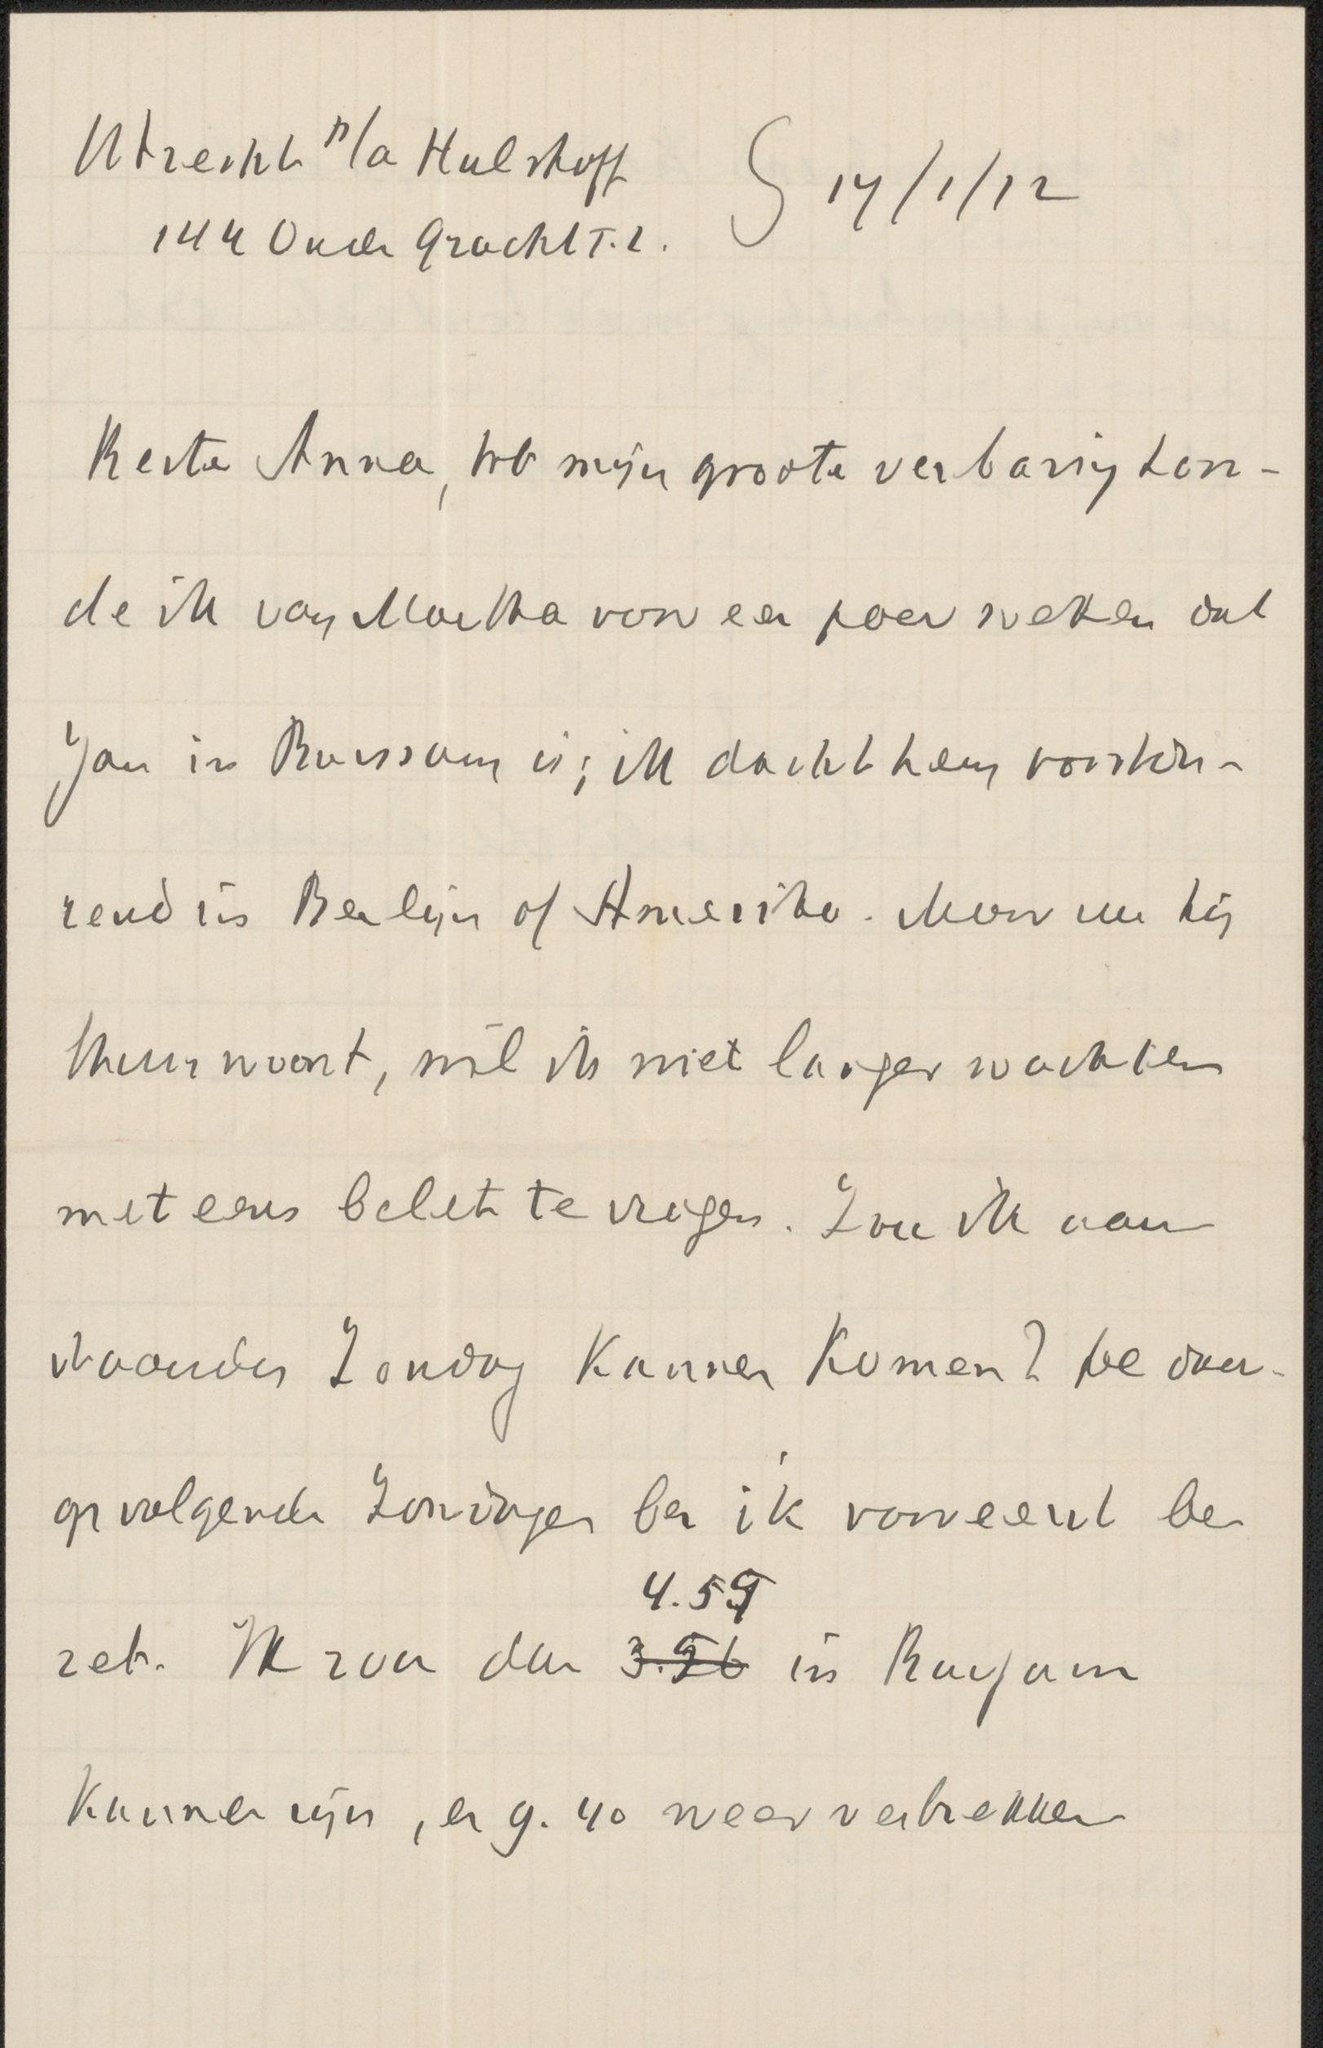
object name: letter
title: Brief aan Anna Dorothea Dirks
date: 1912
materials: ink, paper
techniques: pen, writing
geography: utrecht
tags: deventer, martha van vloten, charitable works, money, the hague, berlin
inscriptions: collector's mark: ‘RPK’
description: Brief bevat antwoord van Anna Dorothea Dirks.